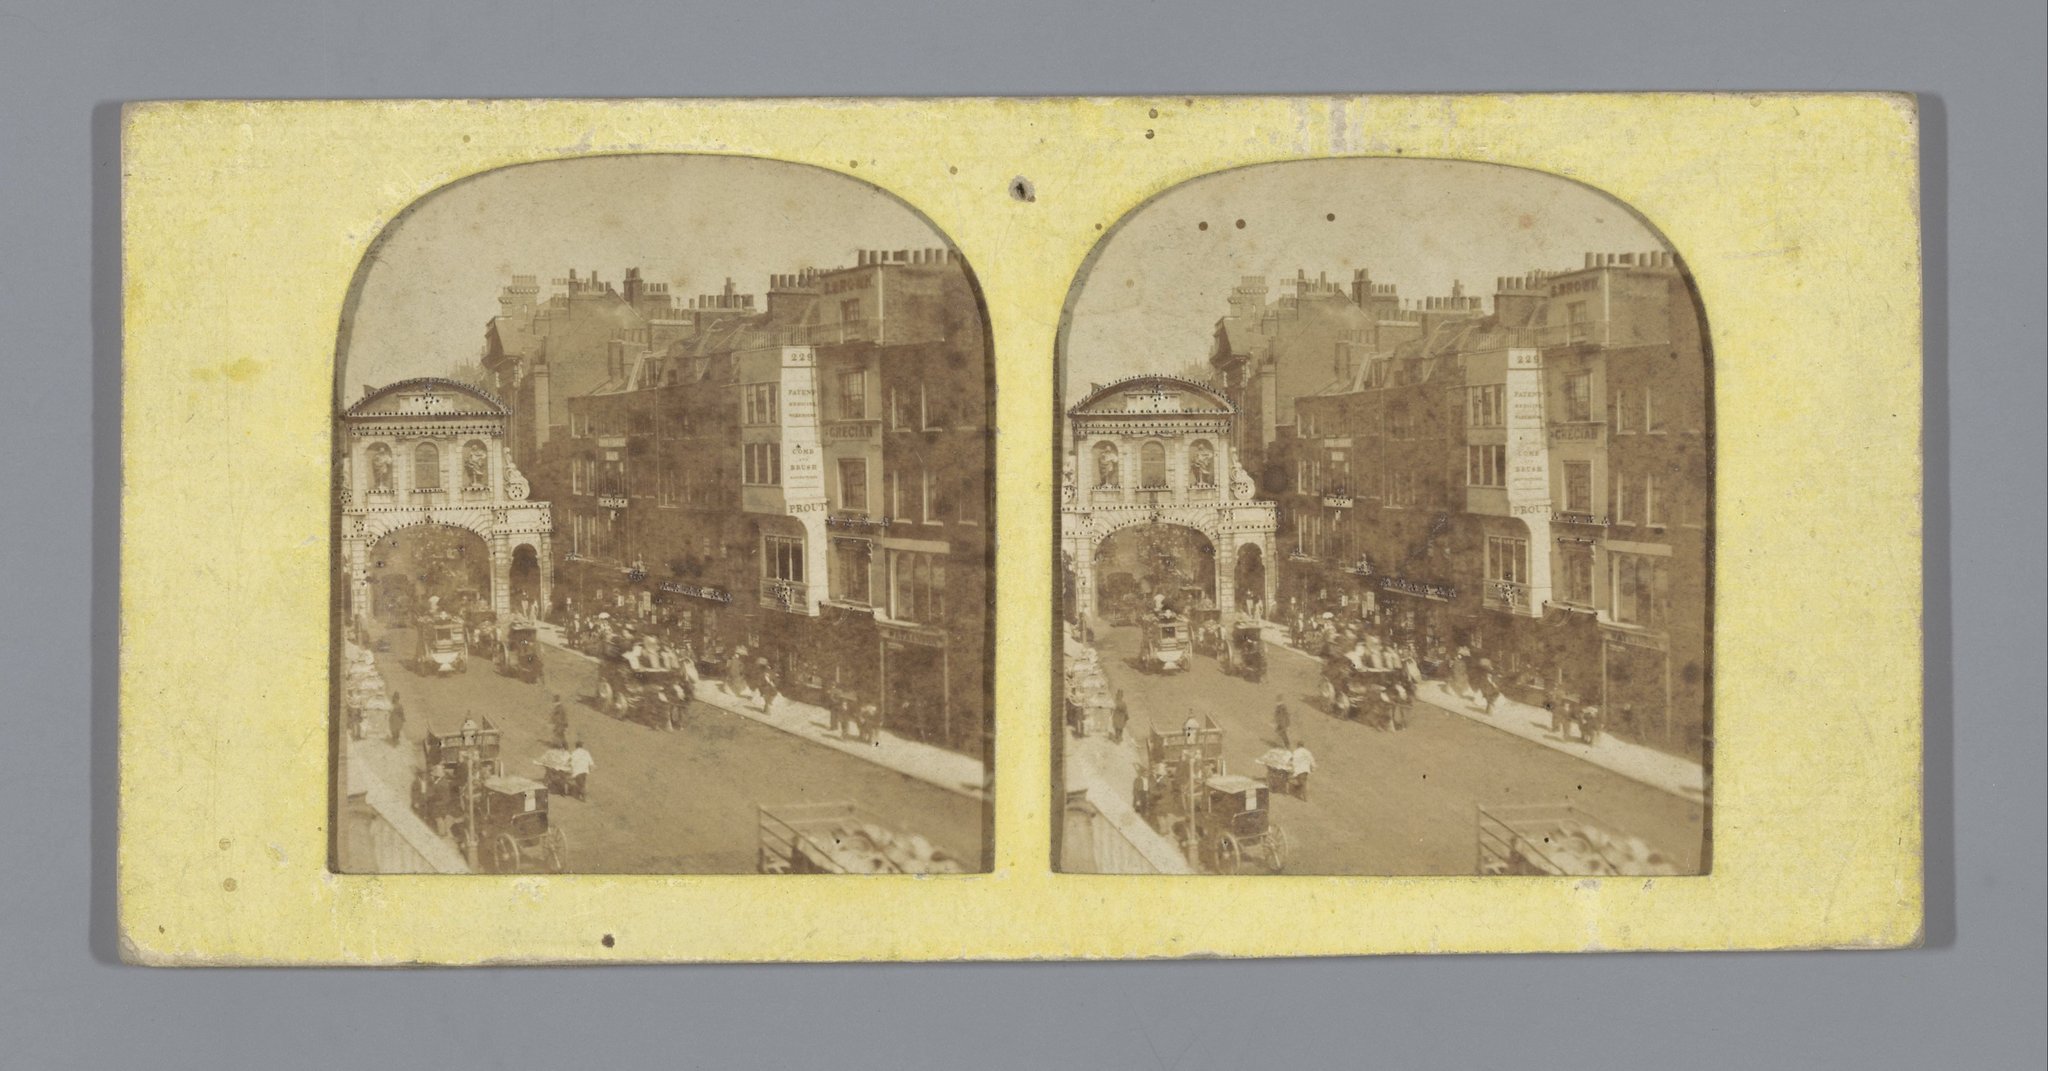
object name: tissue stereograph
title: Straatbeeld in Londen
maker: Anonymous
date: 1855-1863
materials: cardboard, paper, photographic support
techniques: albumen print, hand coloring, perforating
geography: london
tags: urban housing, street, london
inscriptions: retailer's mark: ‘Nolet & Zoon/ Utrecht’, number: ‘No 8’